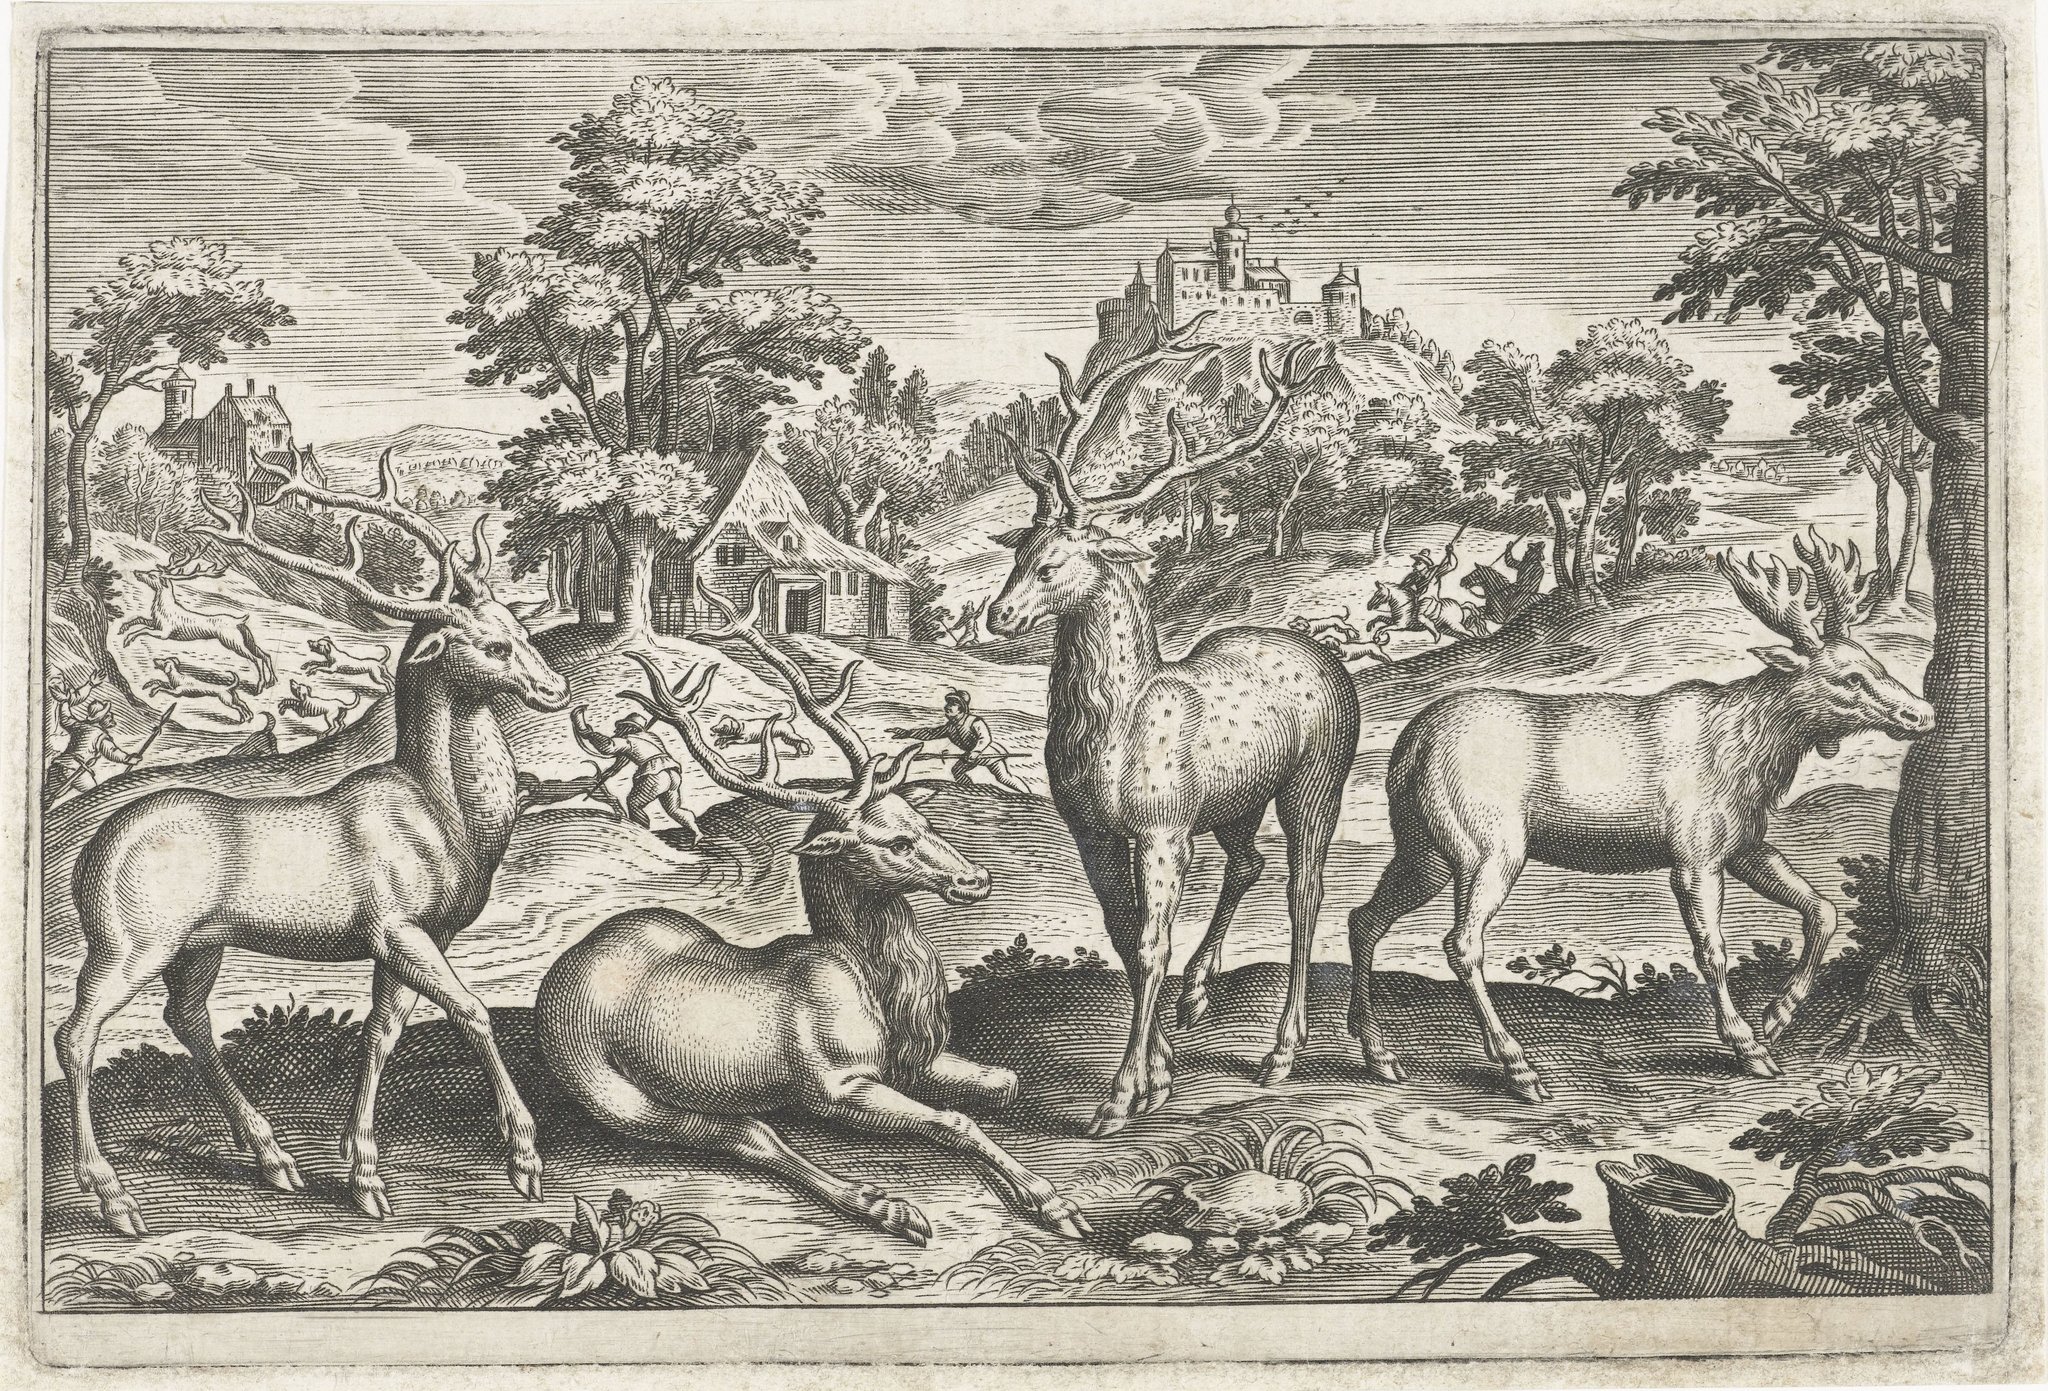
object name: print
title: Animalivm Qvaddrvpedvm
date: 1595-1652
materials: paper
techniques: engraving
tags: hoofed animals: deer, stag-hunting, hoofed animals: moose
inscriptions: collector's mark: Lugt 2228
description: Twee herten, een damhert en een eland op de voorgrond. Op de achtergrond een hertenjacht. De prent maakt deel uit van een serie met dieren als onderwerp.